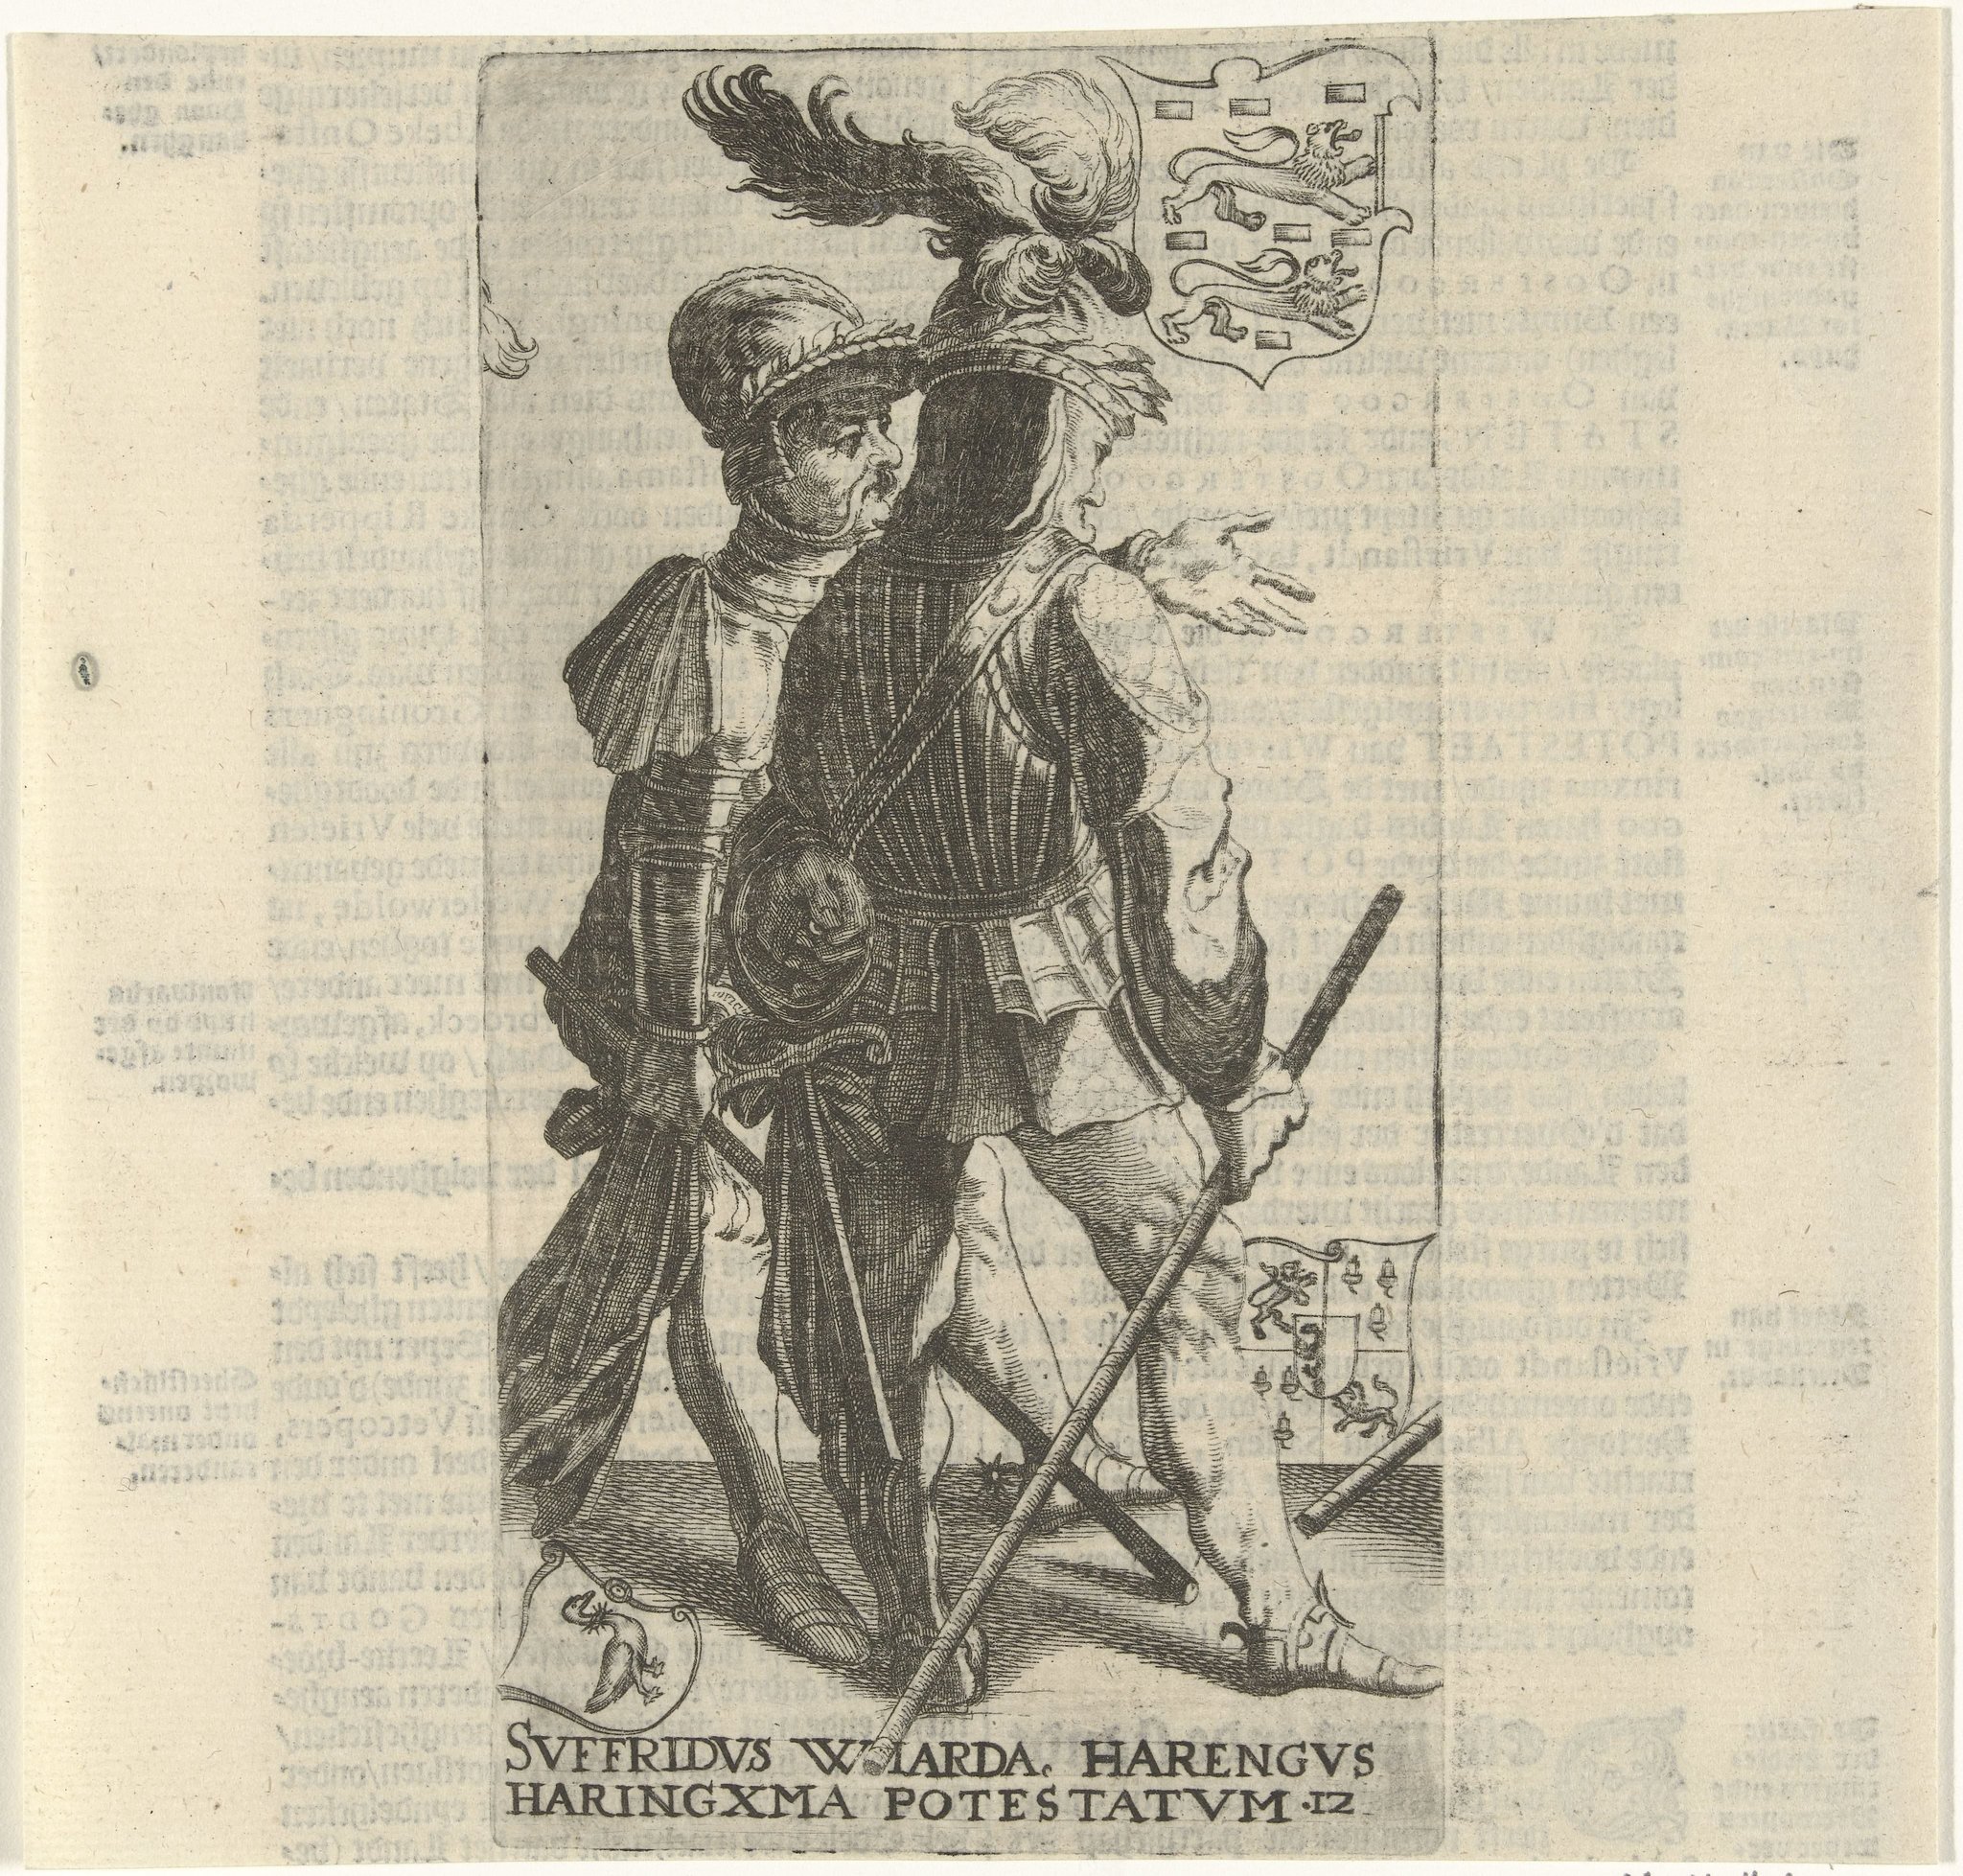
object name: print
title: Sjoerd Wiarda en Haring Harinxma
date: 1622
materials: paper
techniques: etching, letterpress printing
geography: northern netherlands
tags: sjoerd wiarda, heeg, haring haringsma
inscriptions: collector's mark: Lugt 2228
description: De prent is ook als boekillustratie gebruikt in: Winsemius, P.W. Chronique ofte Historische geschiedenisse van Vrieslant (...). Franeker: Joannes Lamrinck, 1622.